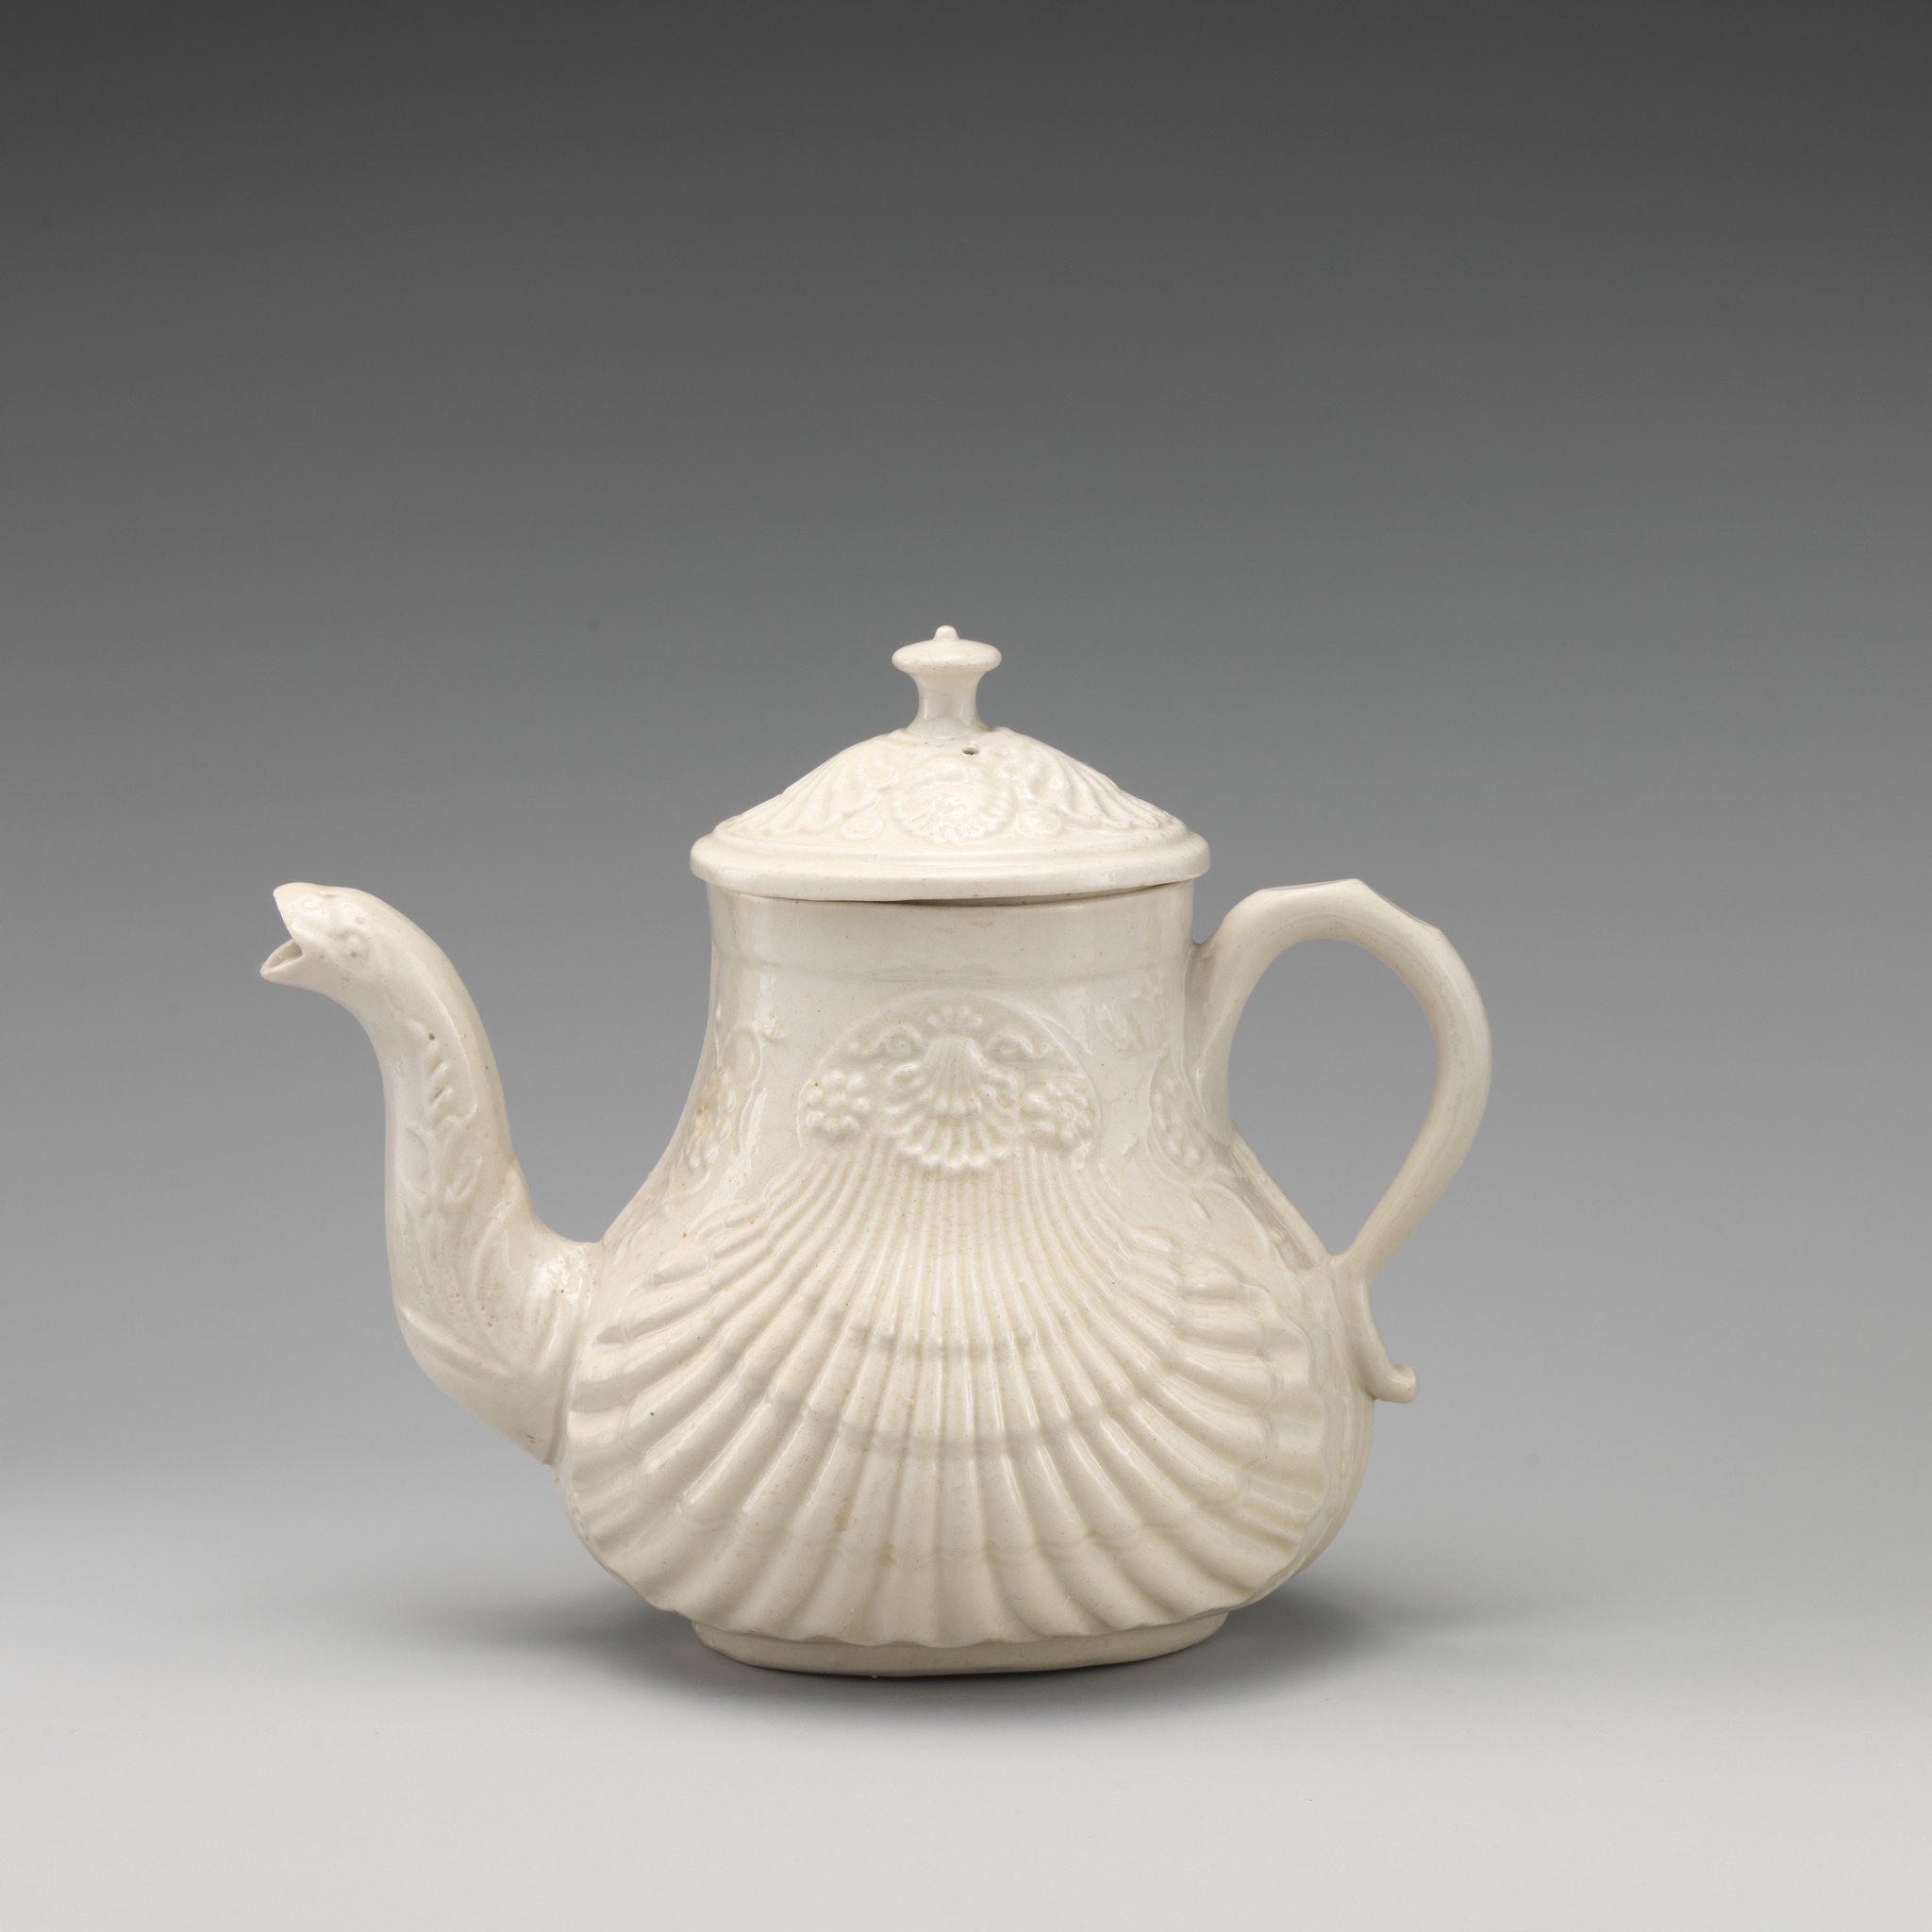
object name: teapot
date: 1750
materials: stoneware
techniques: salt glaze